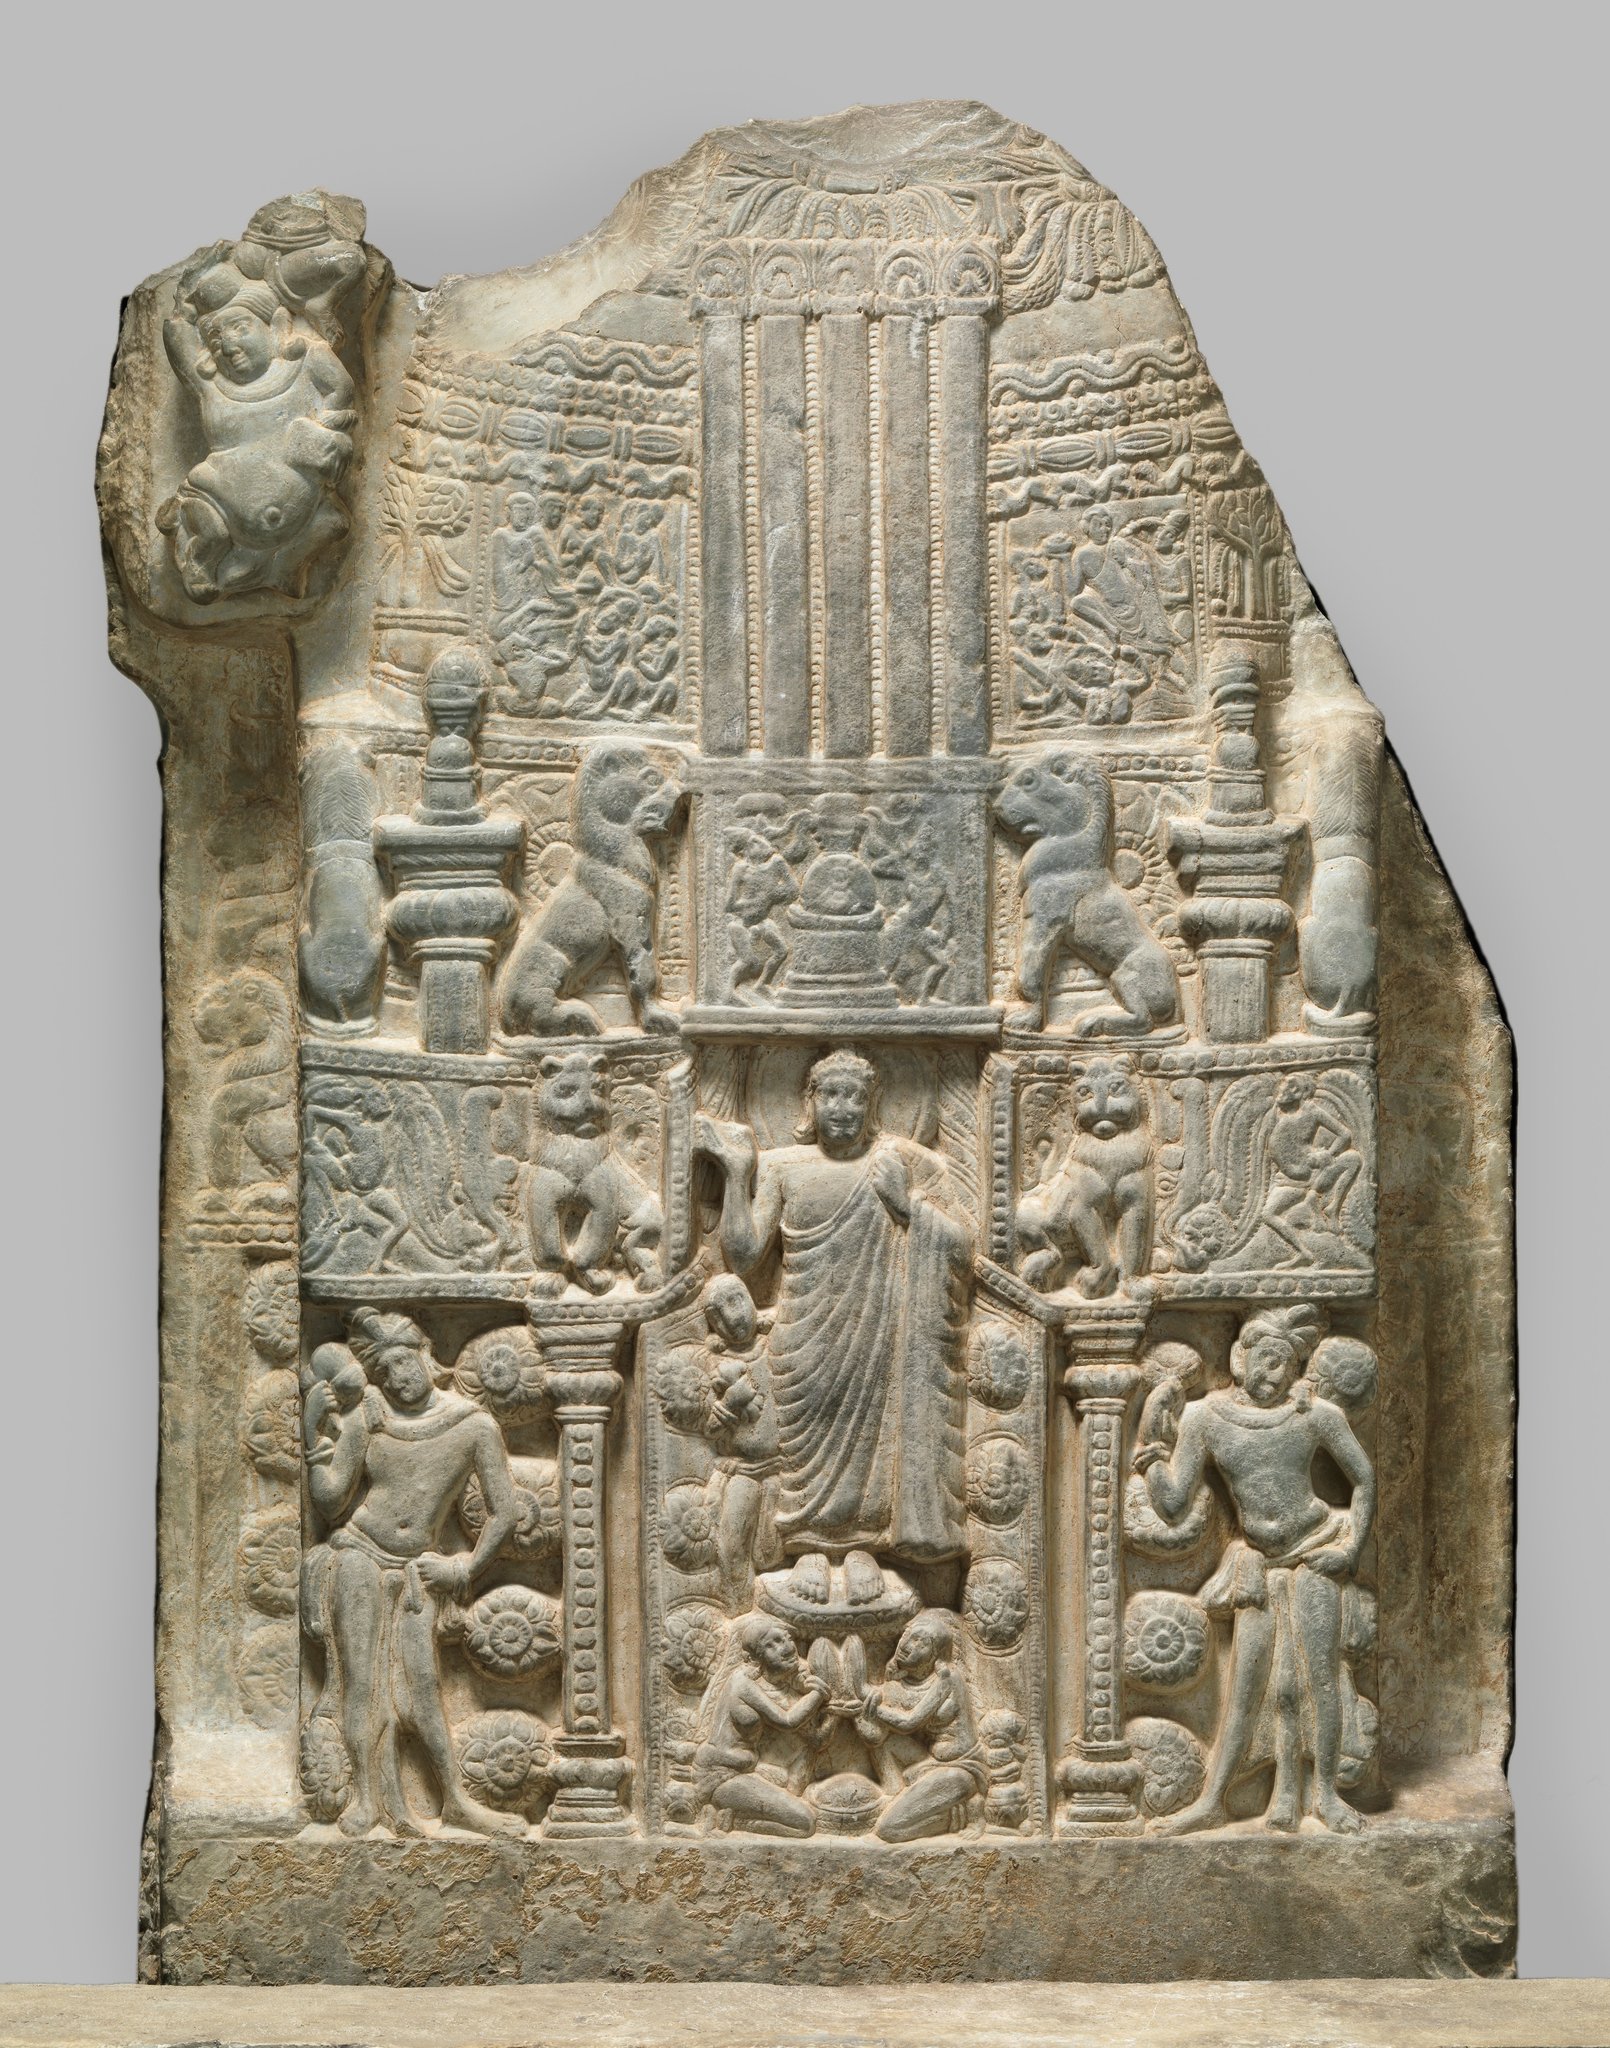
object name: drum slab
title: Drum panel depicting a stupa with the Buddha’s descent from Trayastrimsa Heaven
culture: indian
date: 267-300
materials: limestone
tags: early andhra,lions,buddhism,buddha